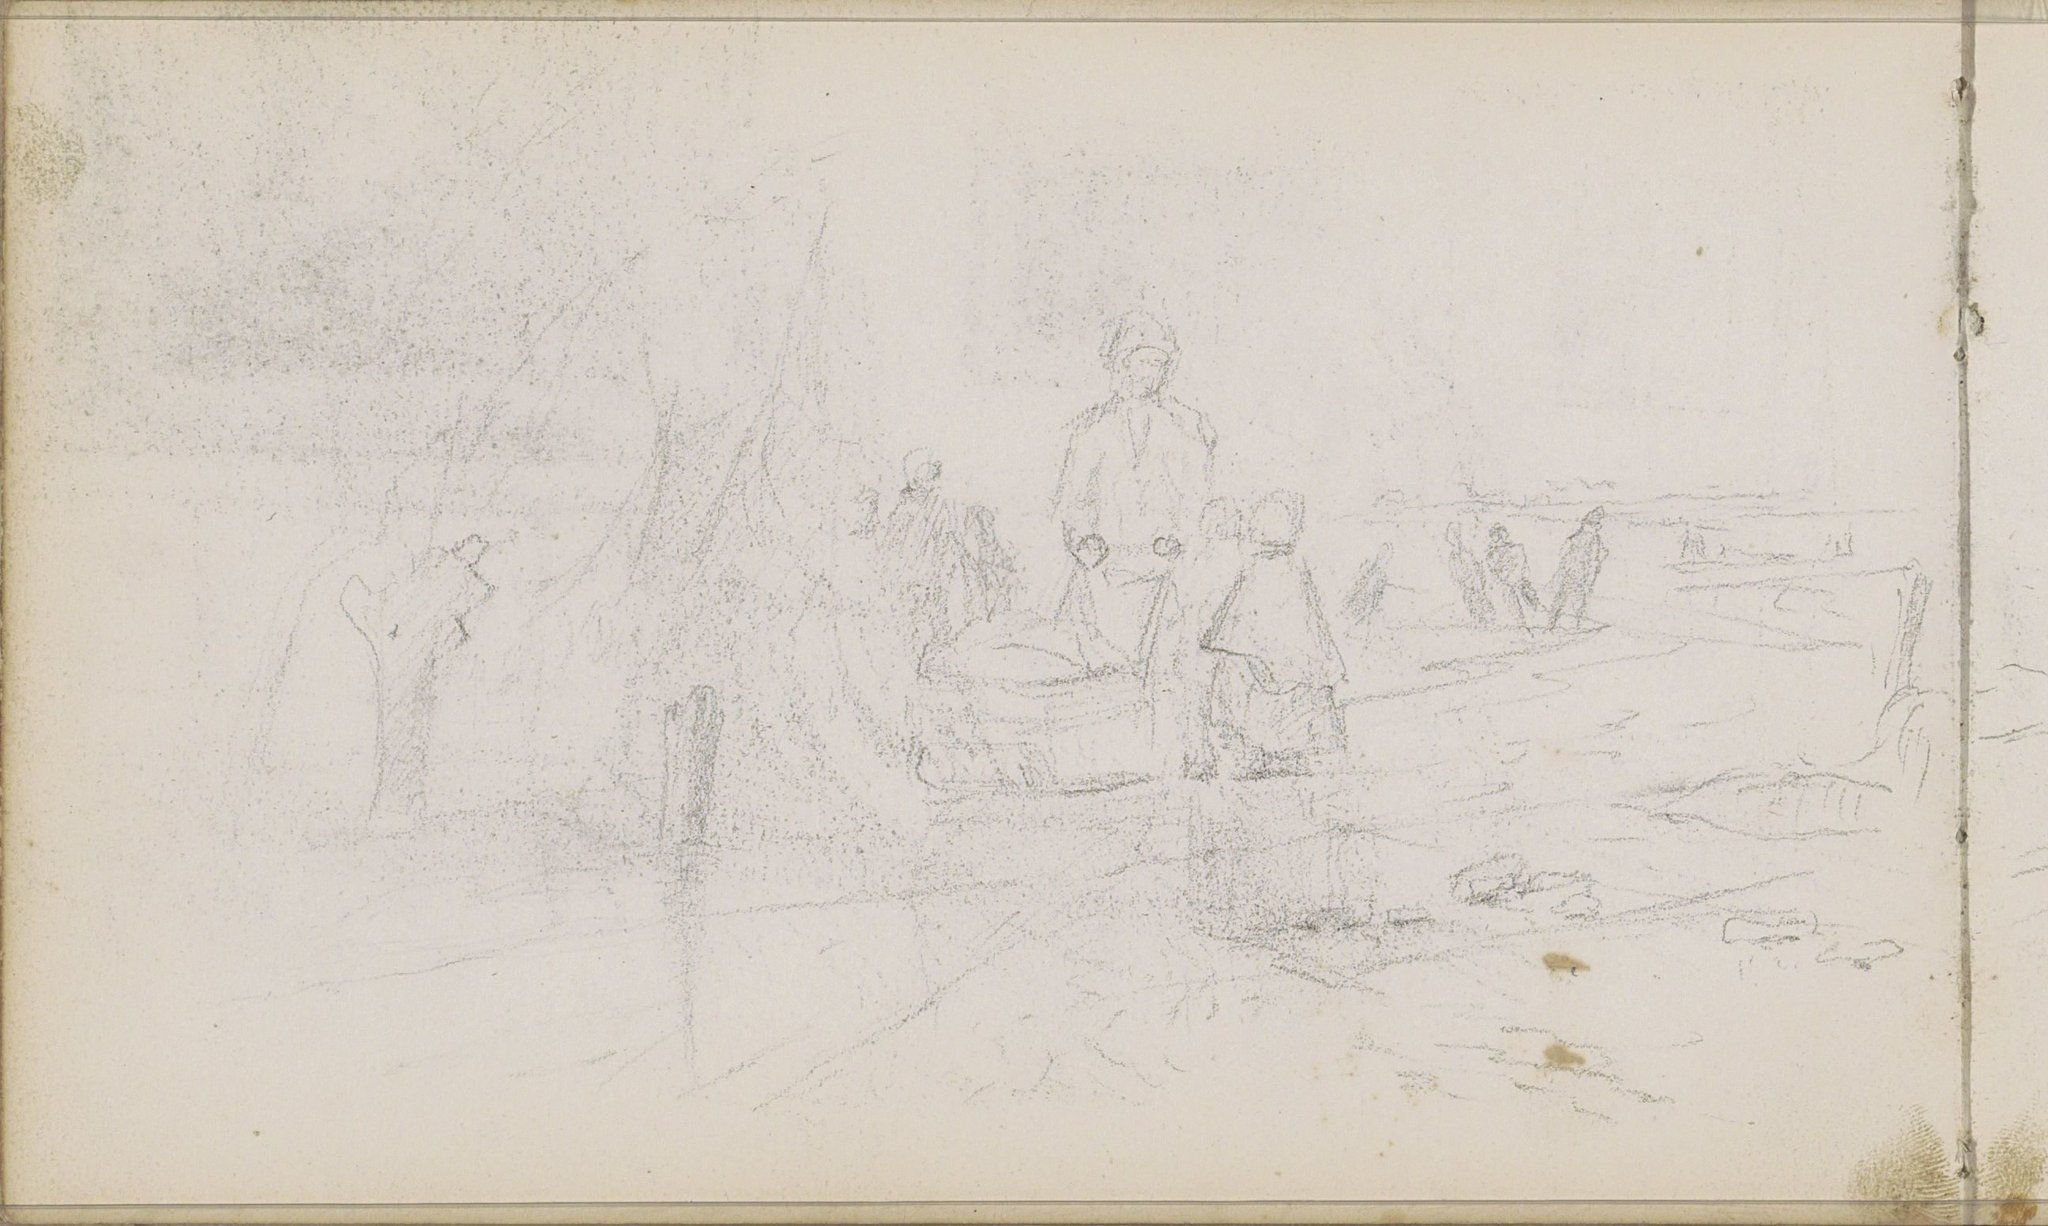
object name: sketchbook leaf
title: IJspret op een bevroren vaart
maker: willem cornelis rip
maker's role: draughtsman, painter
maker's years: 1856-1922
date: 1874-1875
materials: paper, pencil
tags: ice ~ freezing weather, skates (winter sports)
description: Onder andere schaatsers en figuren met een slede op een bevroren vaart. Blad 14 verso uit een schetsboek met 46 bladen.